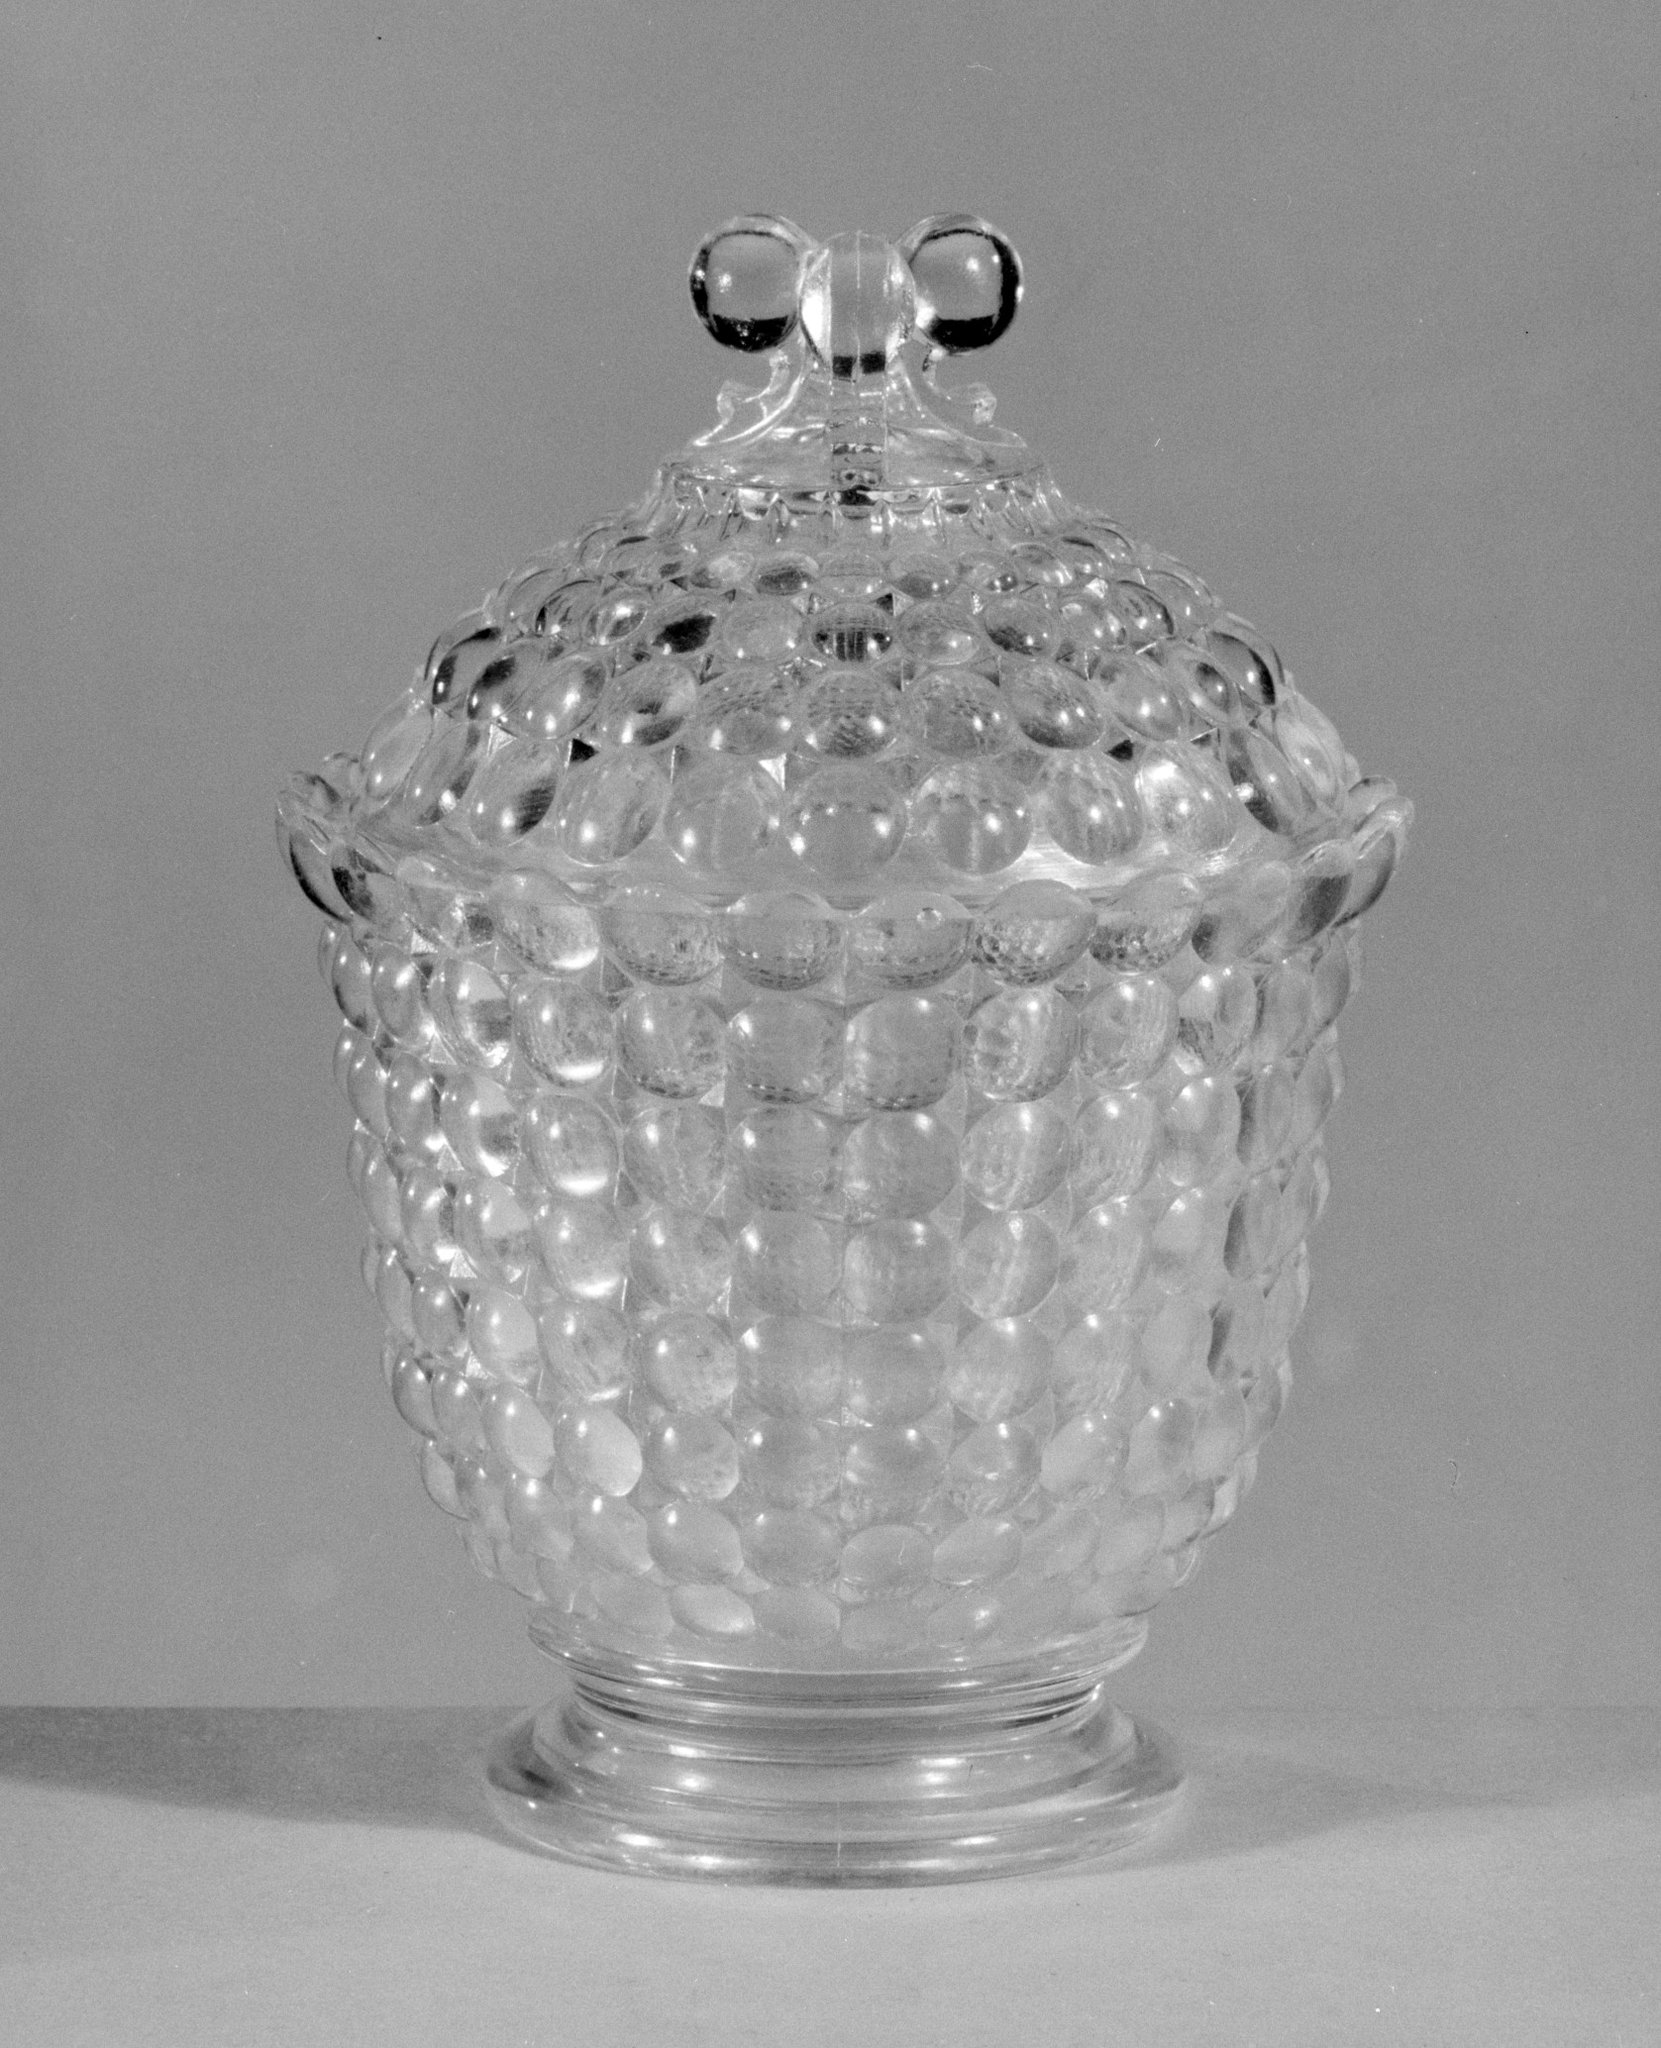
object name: marmalade jar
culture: american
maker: adams and company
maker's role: maker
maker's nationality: american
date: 1870-1890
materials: glass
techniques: pressed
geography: united states